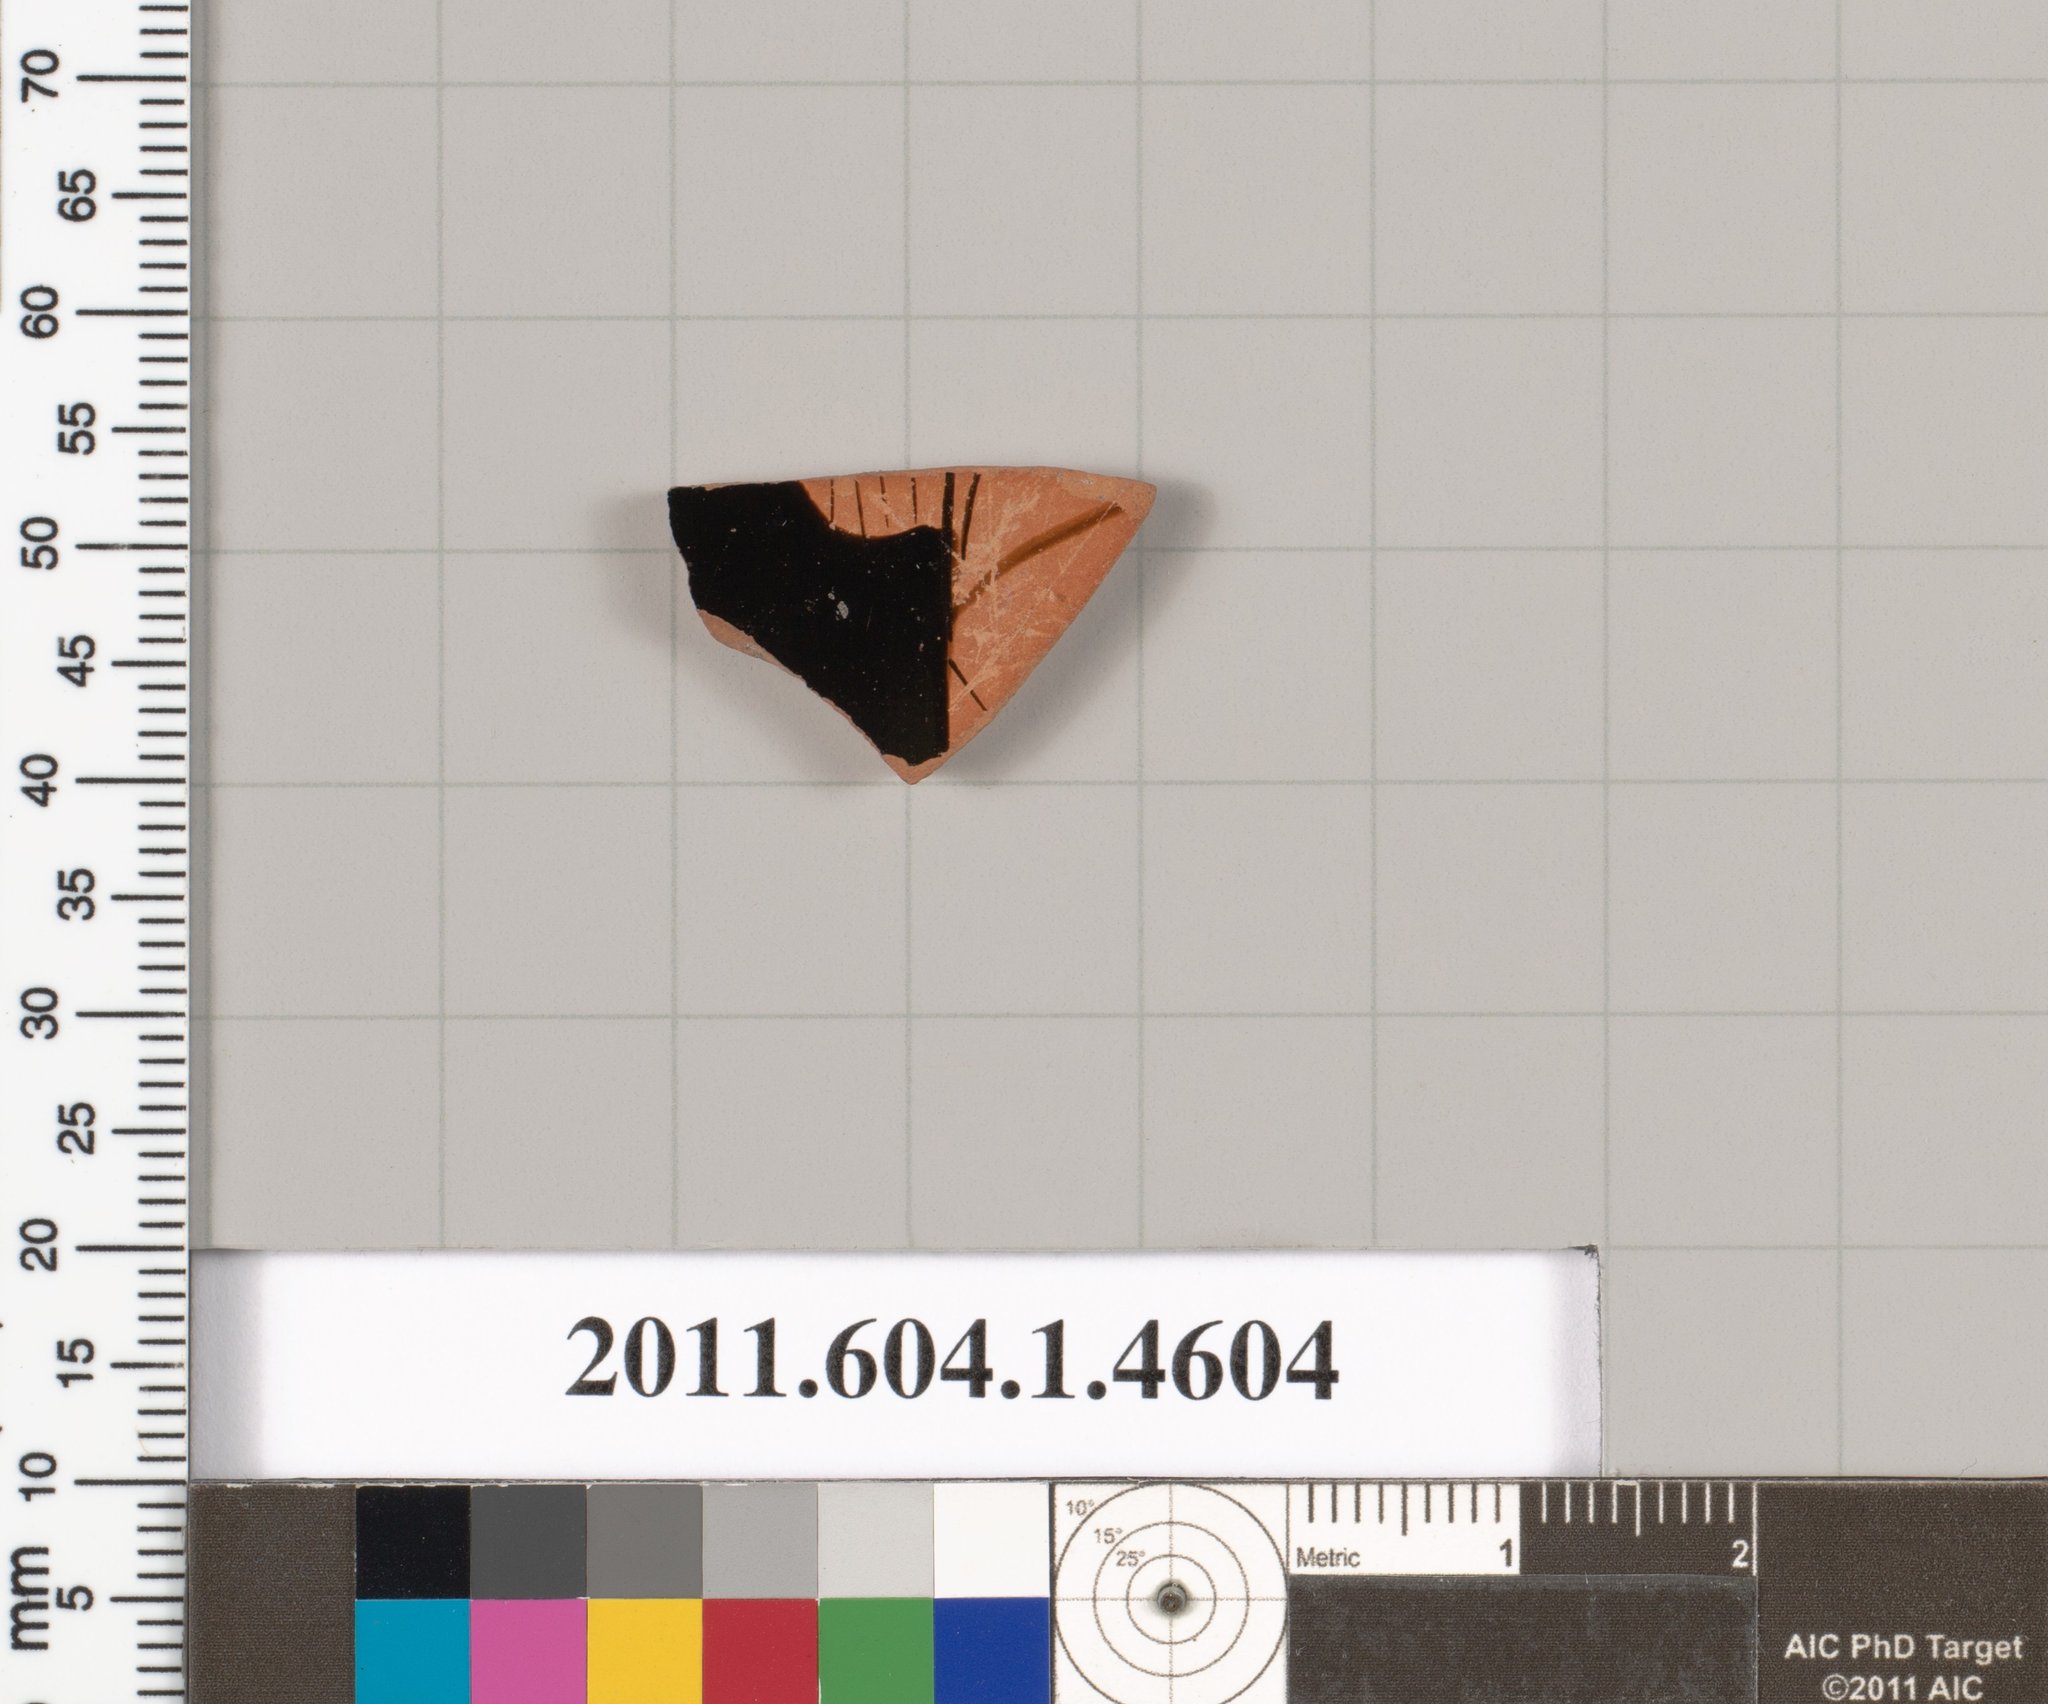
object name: kylix fragment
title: Terracotta fragment of a kylix (drinking cup)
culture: greek, attic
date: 467-435 BCE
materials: terracotta